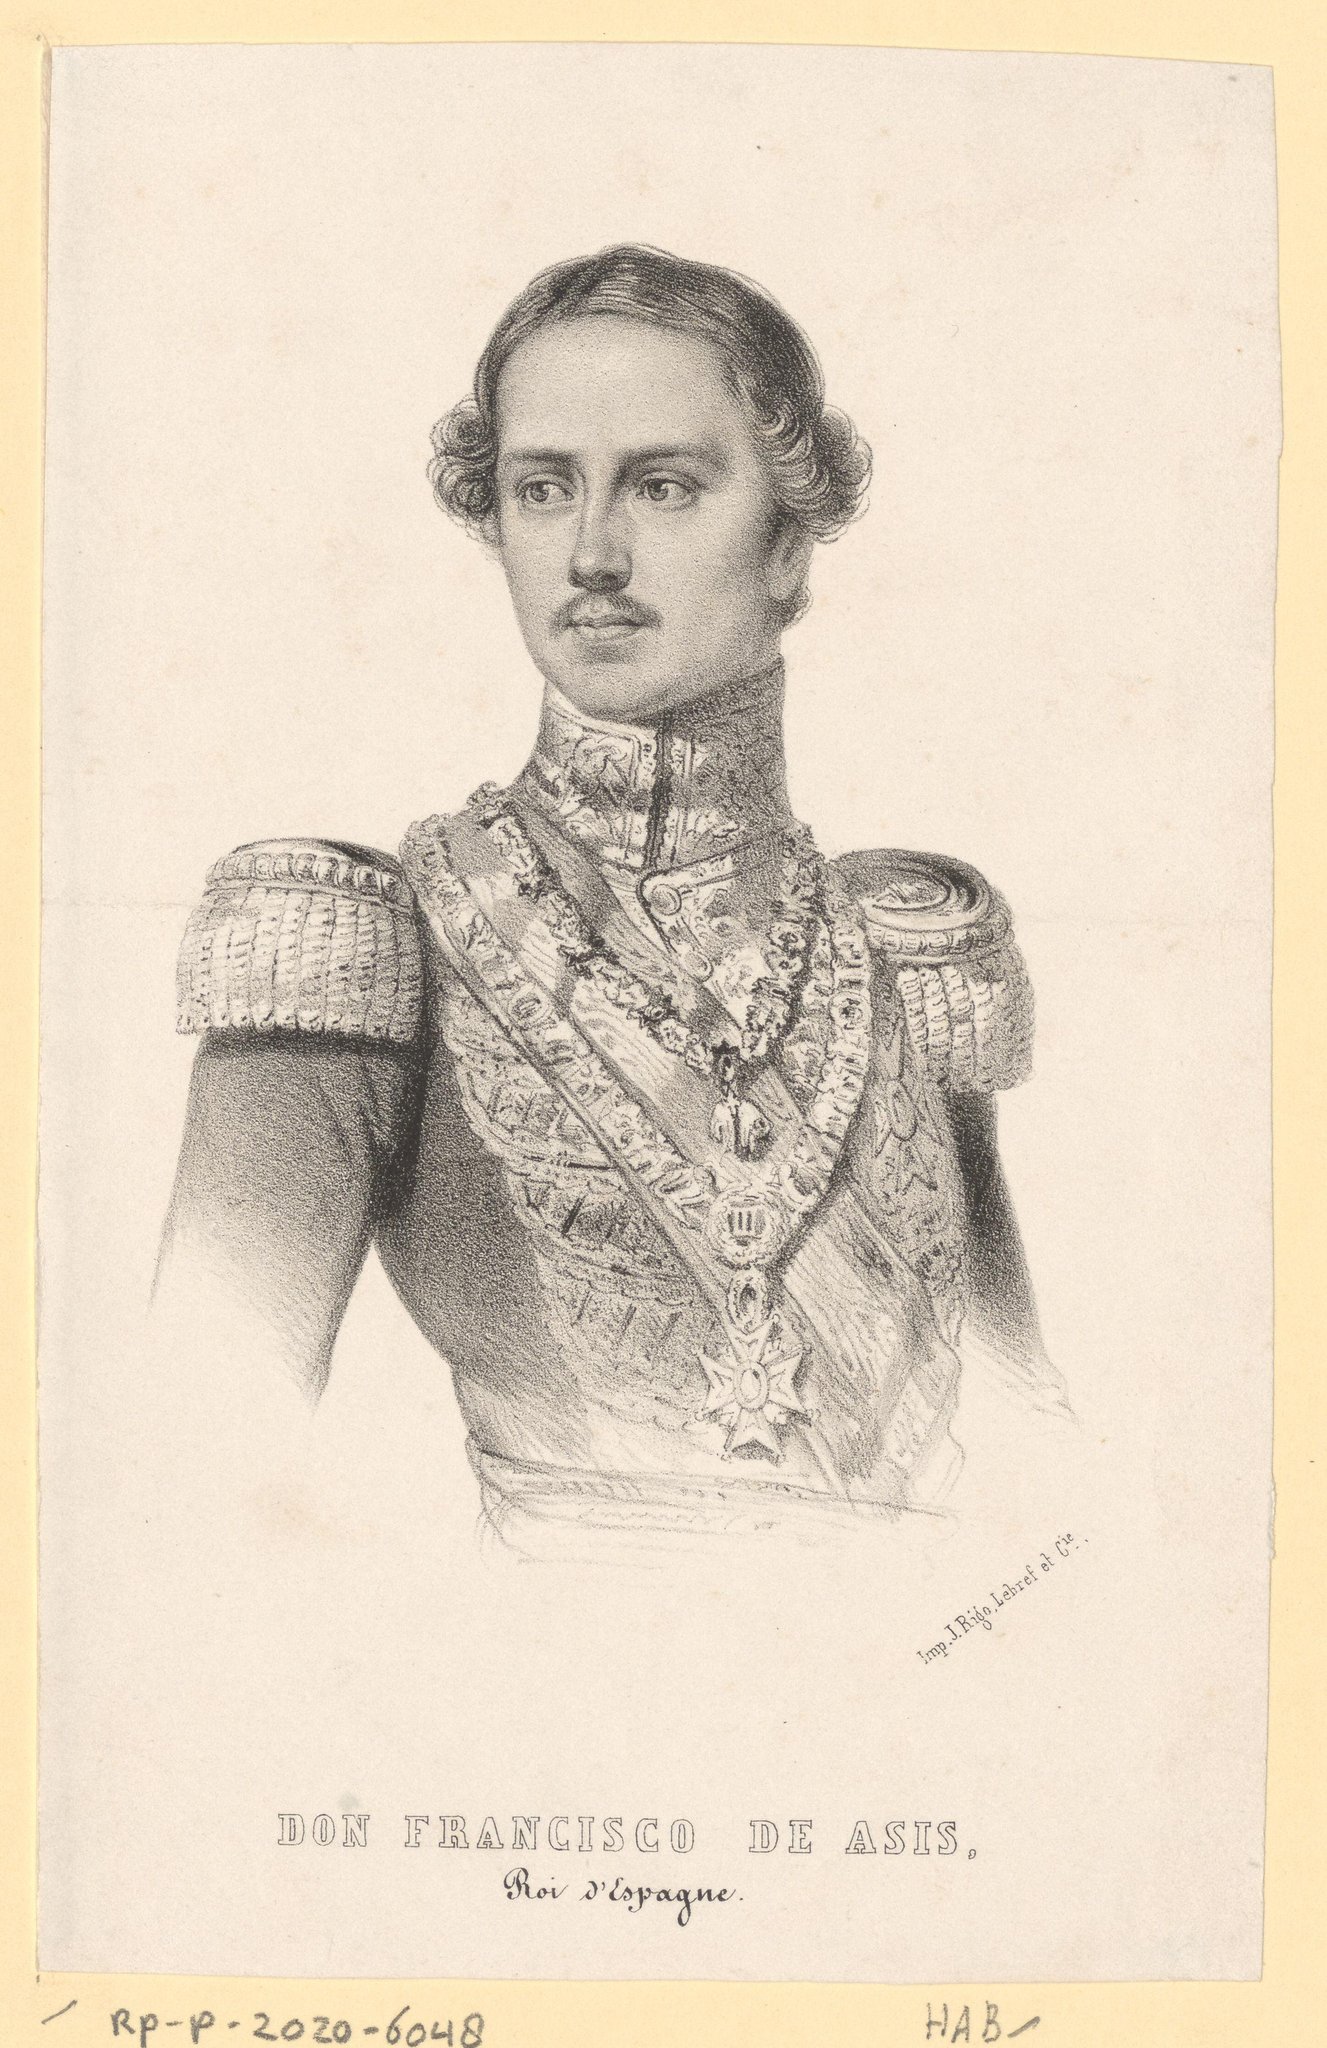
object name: print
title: Portret van Frans van Assisi van Bourbon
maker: Anonymous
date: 1846-1847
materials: paper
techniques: lithograph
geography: paris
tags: historical persons, knighthood order of the golden fleece - insignia of a knighthood order, e.g.: badge, chain (with name of order), king